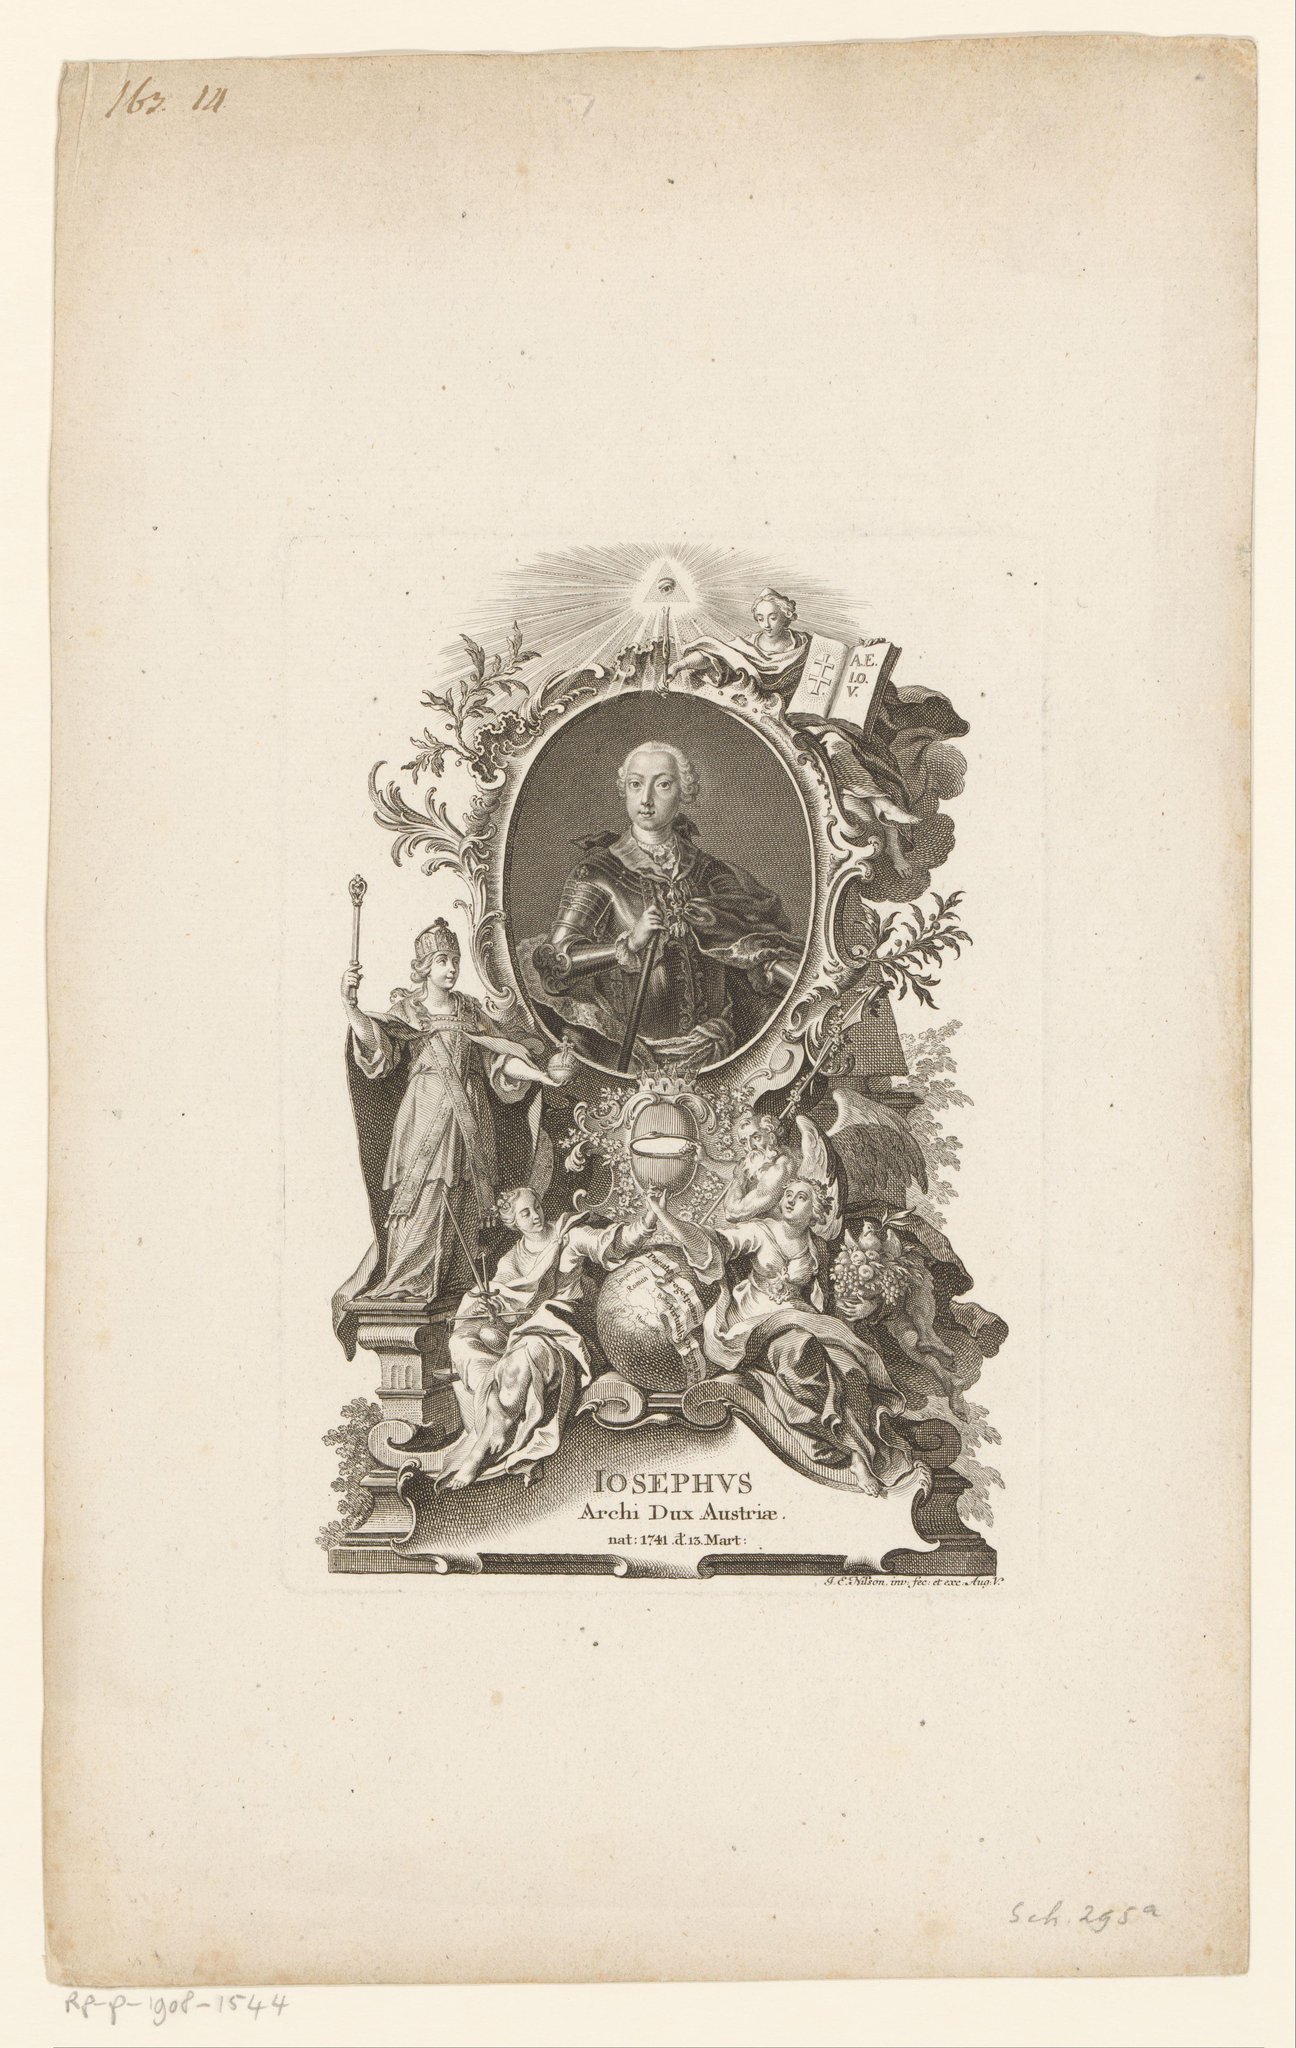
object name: print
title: Portret van Jozef II, Rooms-Duits keizer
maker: johann esaias nilson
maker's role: draughtsman, print maker, publisher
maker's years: 1721-1788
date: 1746-1788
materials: paper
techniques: engraving, etching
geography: augsburg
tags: vienna, jozef ii (duits keizer), peace and justice kissing (cf. ps. 85:10), armour, insignia of the pope, e.g. tiara, historical persons, justitia (justice) as roman personification, serpent ouroboros, knighthood order of the golden fleece - insignia of a knighthood order, e.g.: badge, chain (with name of order), globe, baton of general, father time, man with wings and scythe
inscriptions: collector's mark: Lugt 2228